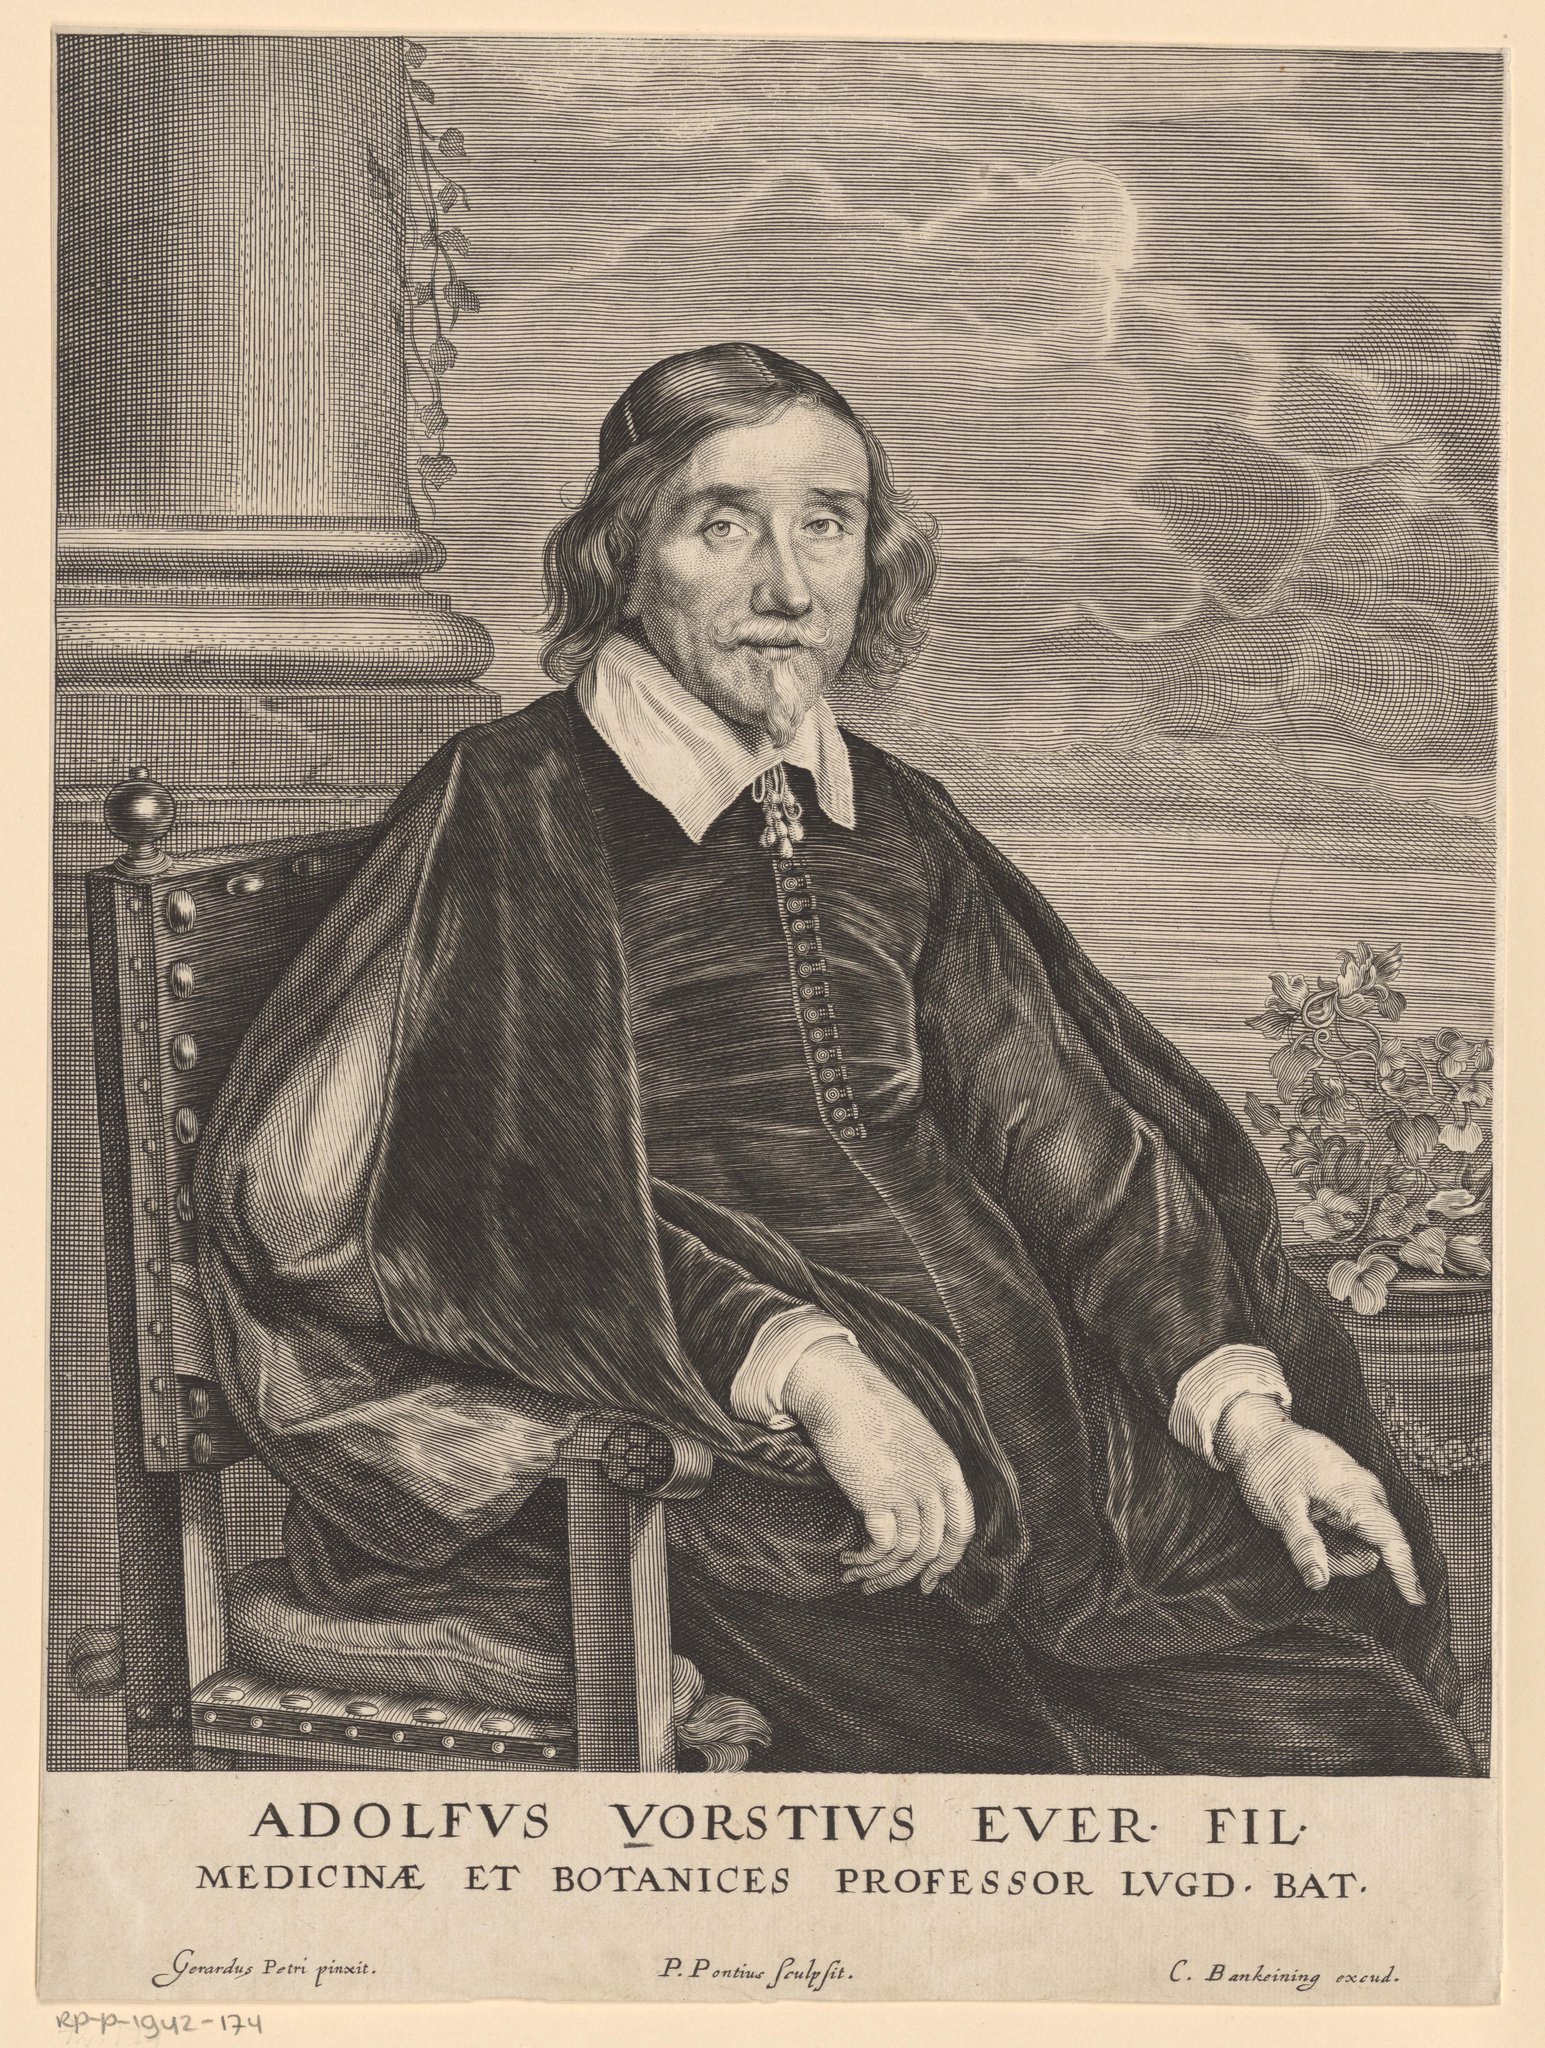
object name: print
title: Portret van de Adolph Vorstius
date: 1647-1657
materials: paper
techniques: engraving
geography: antwerp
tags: delft, scholar, philosopher, historical persons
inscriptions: collector's mark: Lugt 2760, collector's mark: Lugt 2228